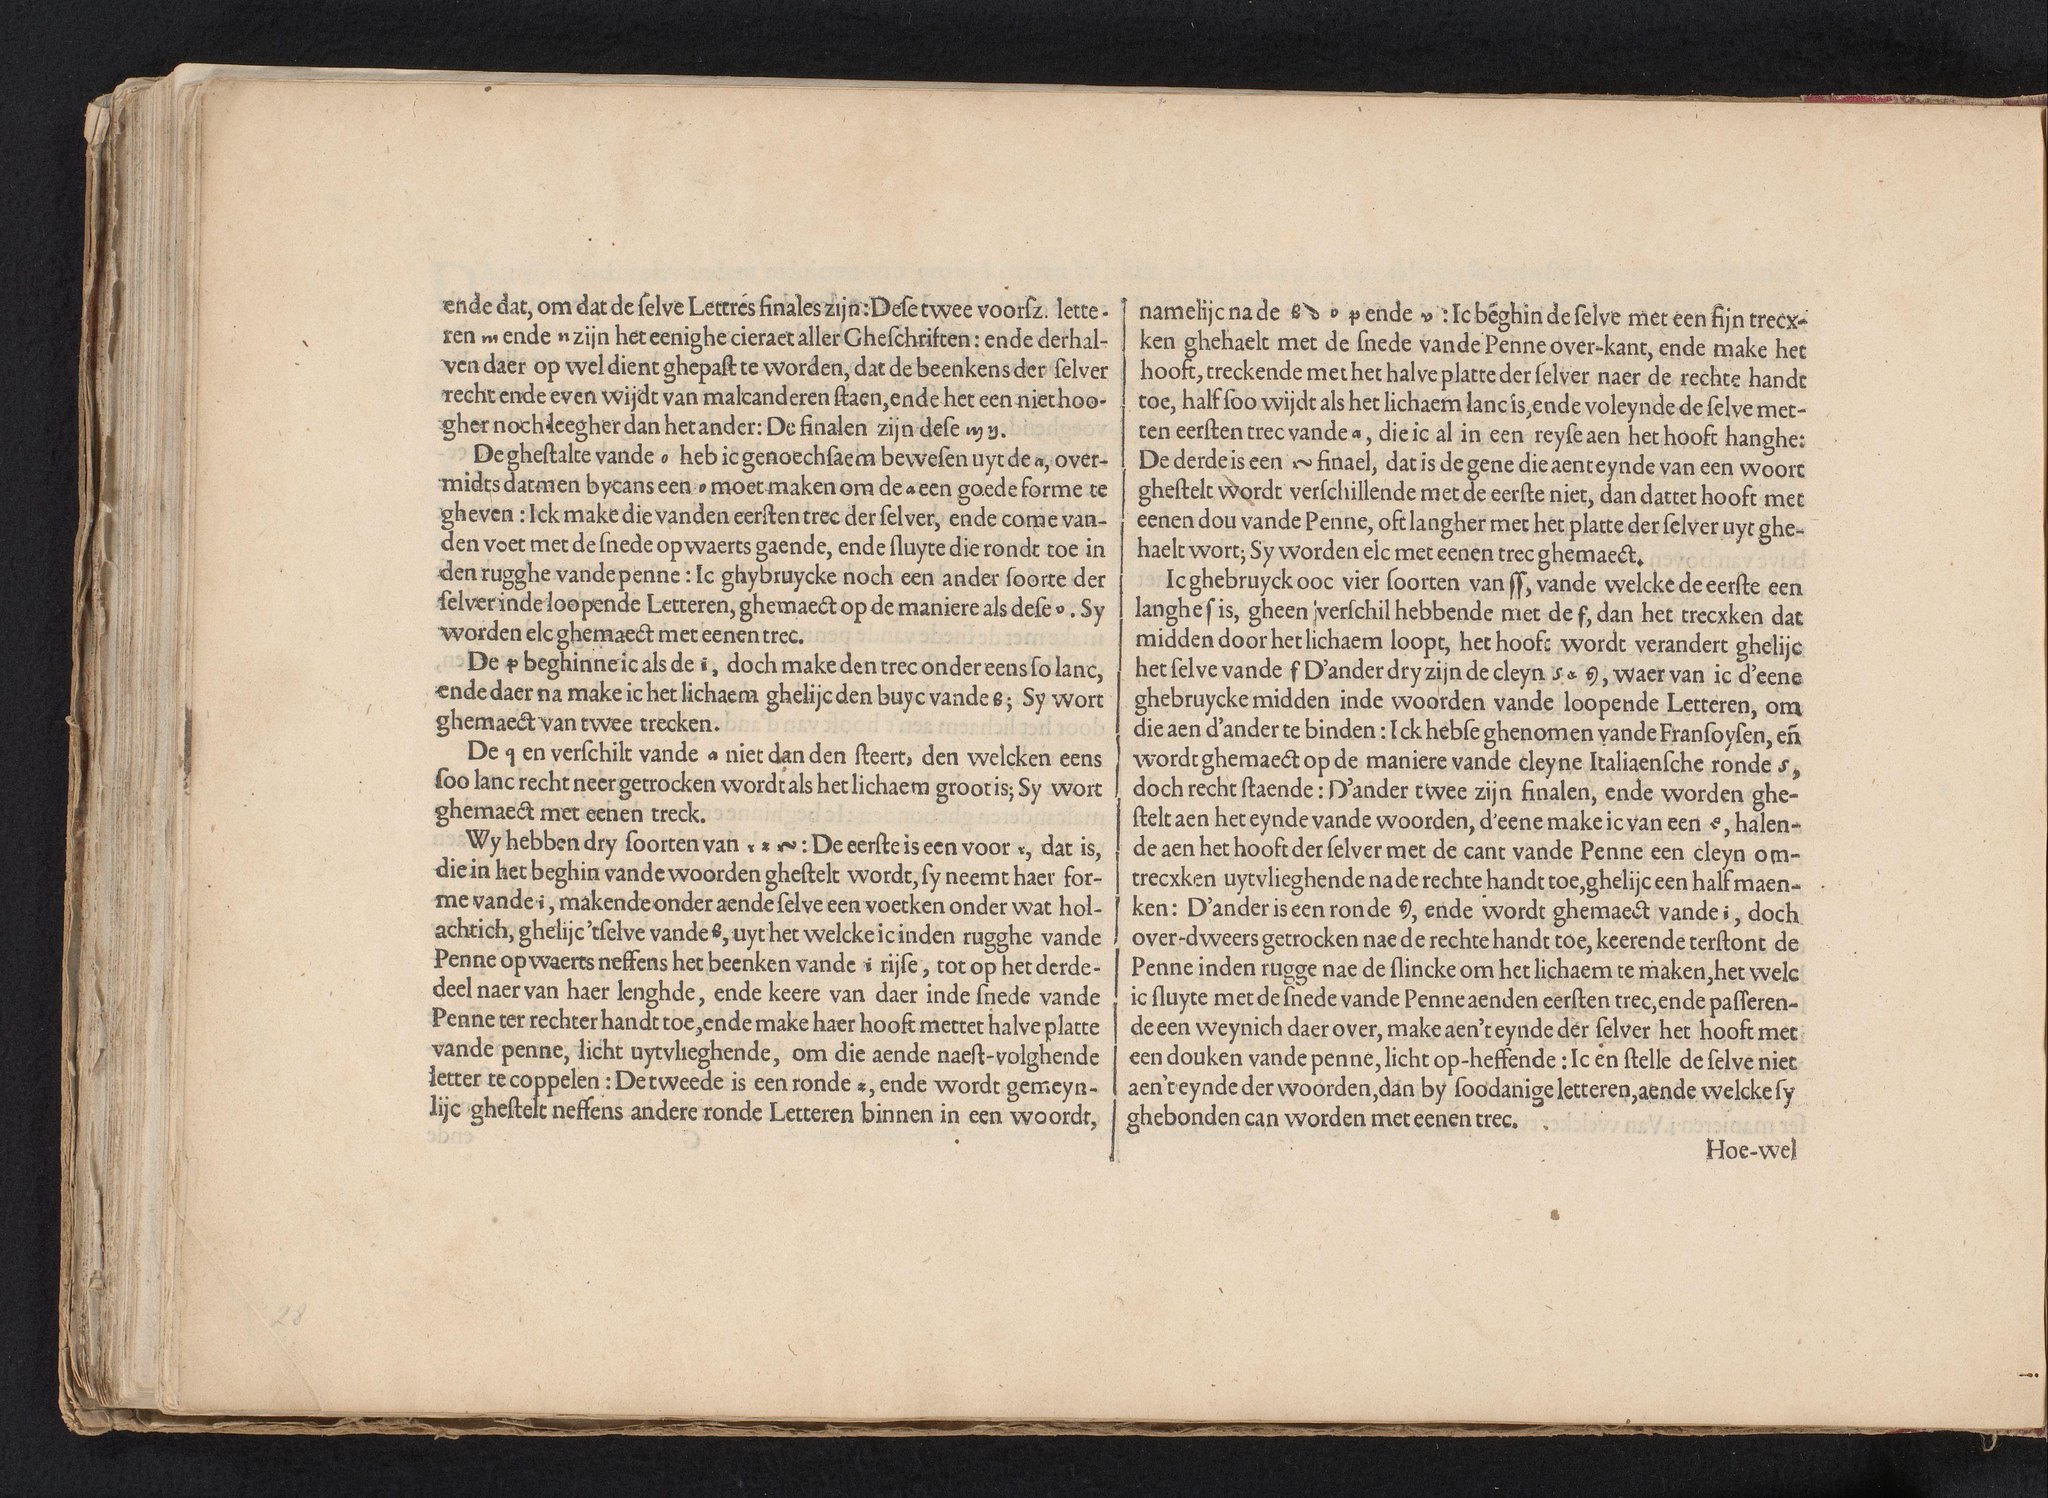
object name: text sheet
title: Spieghel der schrijfkonste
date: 1608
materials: paper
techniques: letterpress printing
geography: amsterdam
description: Folio G1v met het derde vervolg van de instructie bij het schrijven van de Nederlandse letteren. Het blad maakt deel uit van een album.